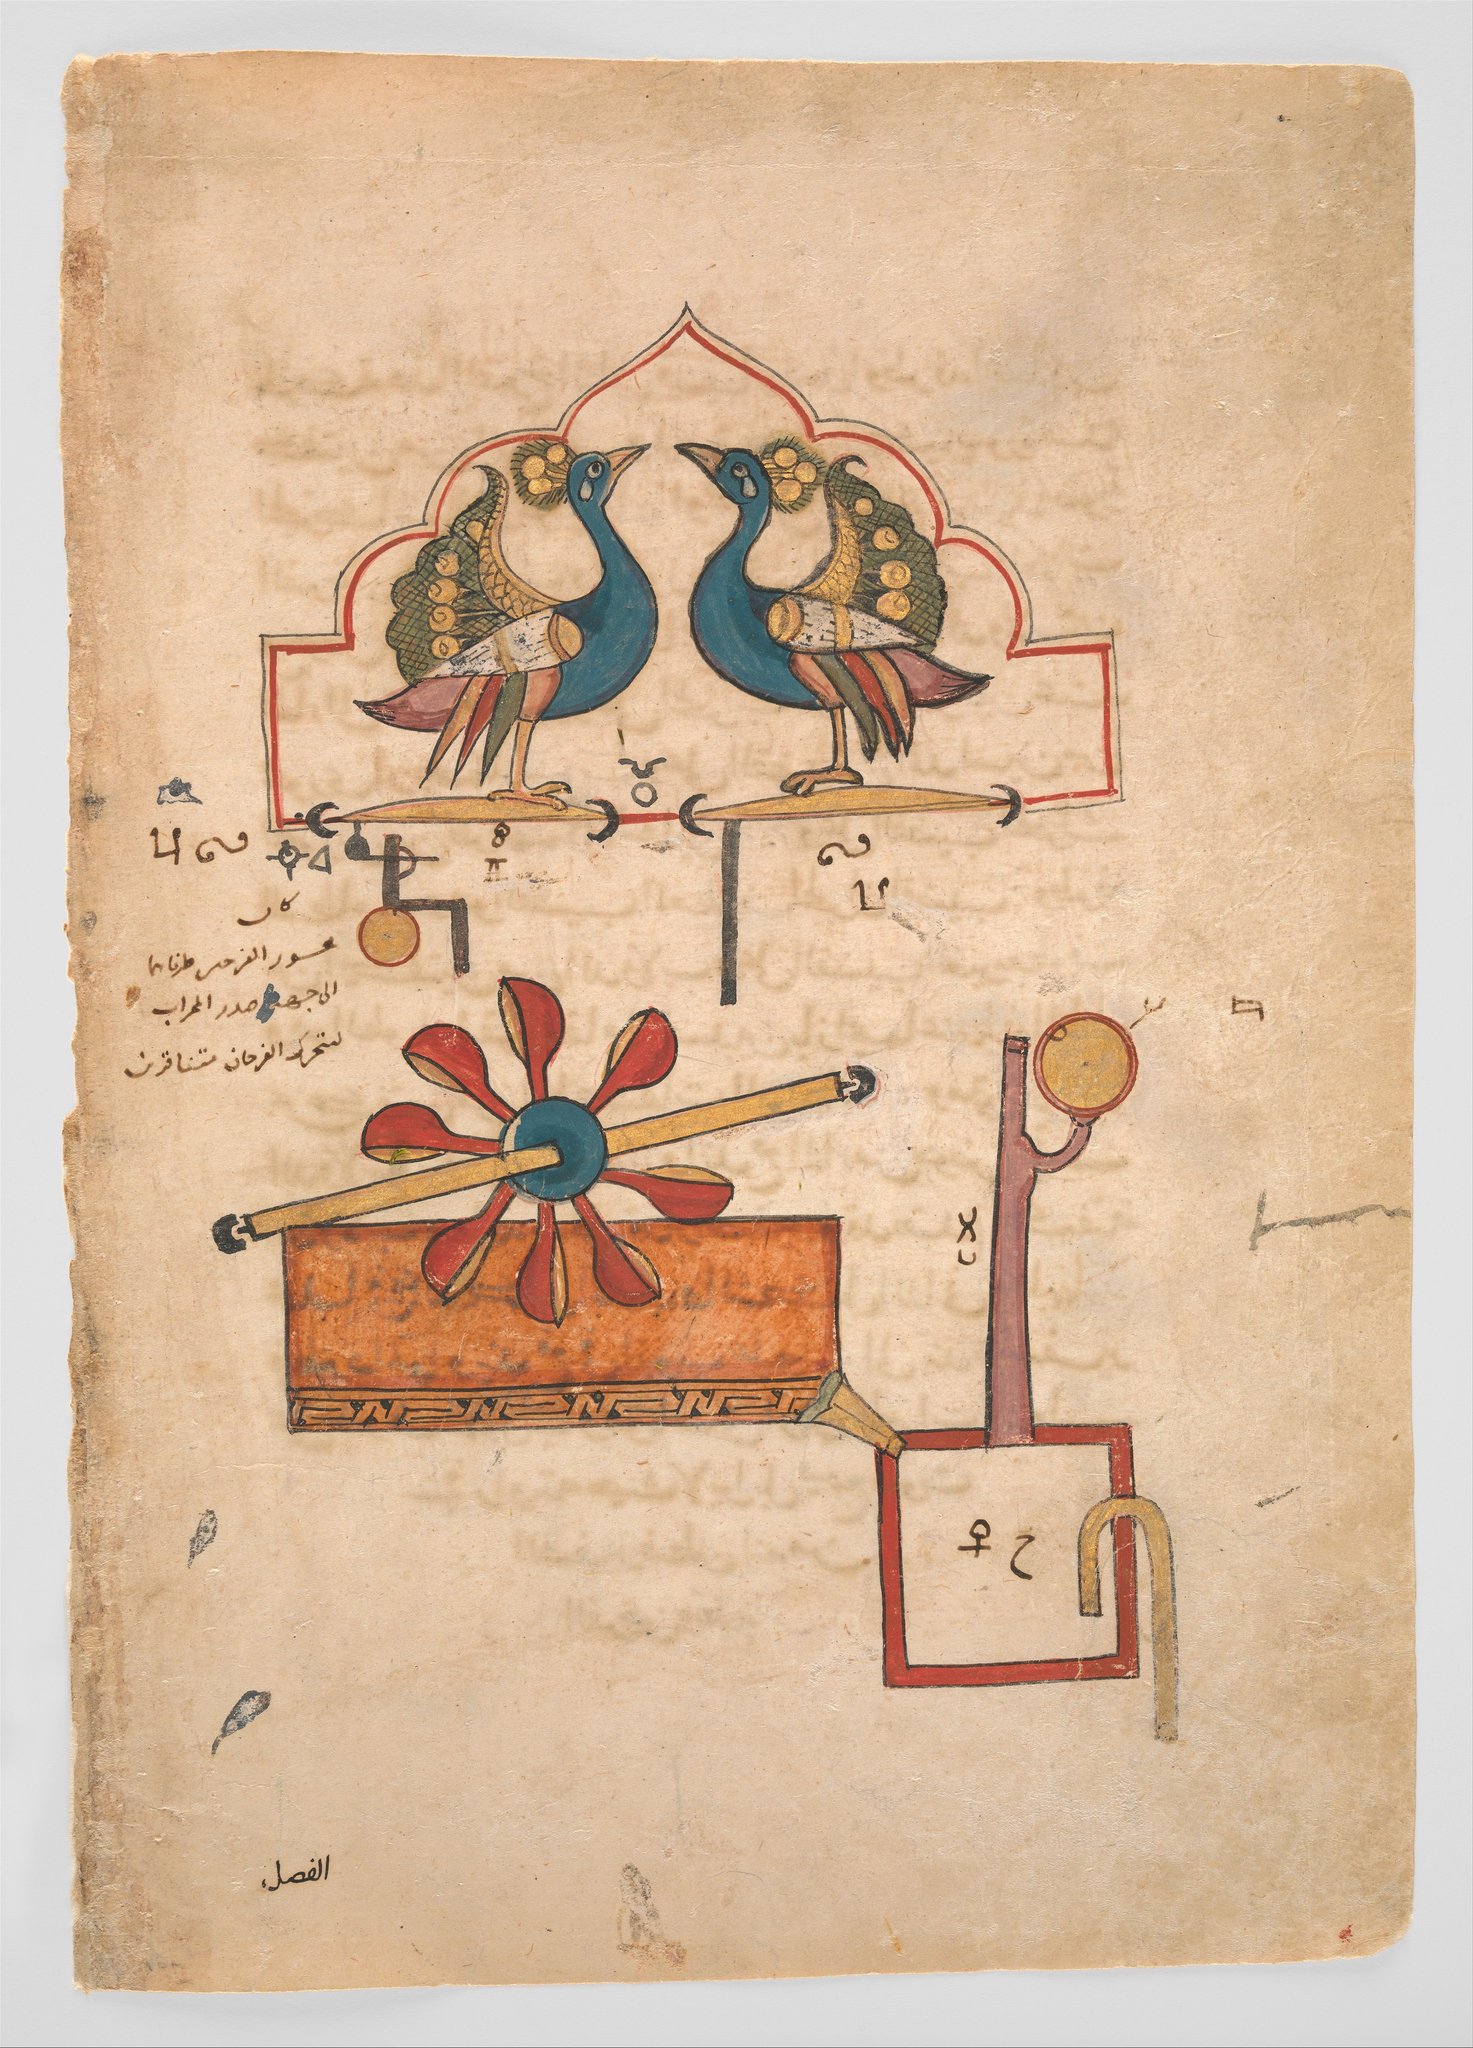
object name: folio from an illustrated manuscript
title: "Design for the Water Clock of the Peacocks", from the Kitab fi ma'rifat al-hiyal al-handasiyya (Book of the Knowledge of Ingenious Mechanical Devices) by Badi' al-Zaman b. al Razzaz al-Jazari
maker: badi' al-zaman ibn al-razzaz al-jazari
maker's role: author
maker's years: 1136-1206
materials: gold, ink, paper, watercolor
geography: syria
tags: arabic,peacocks,clocks